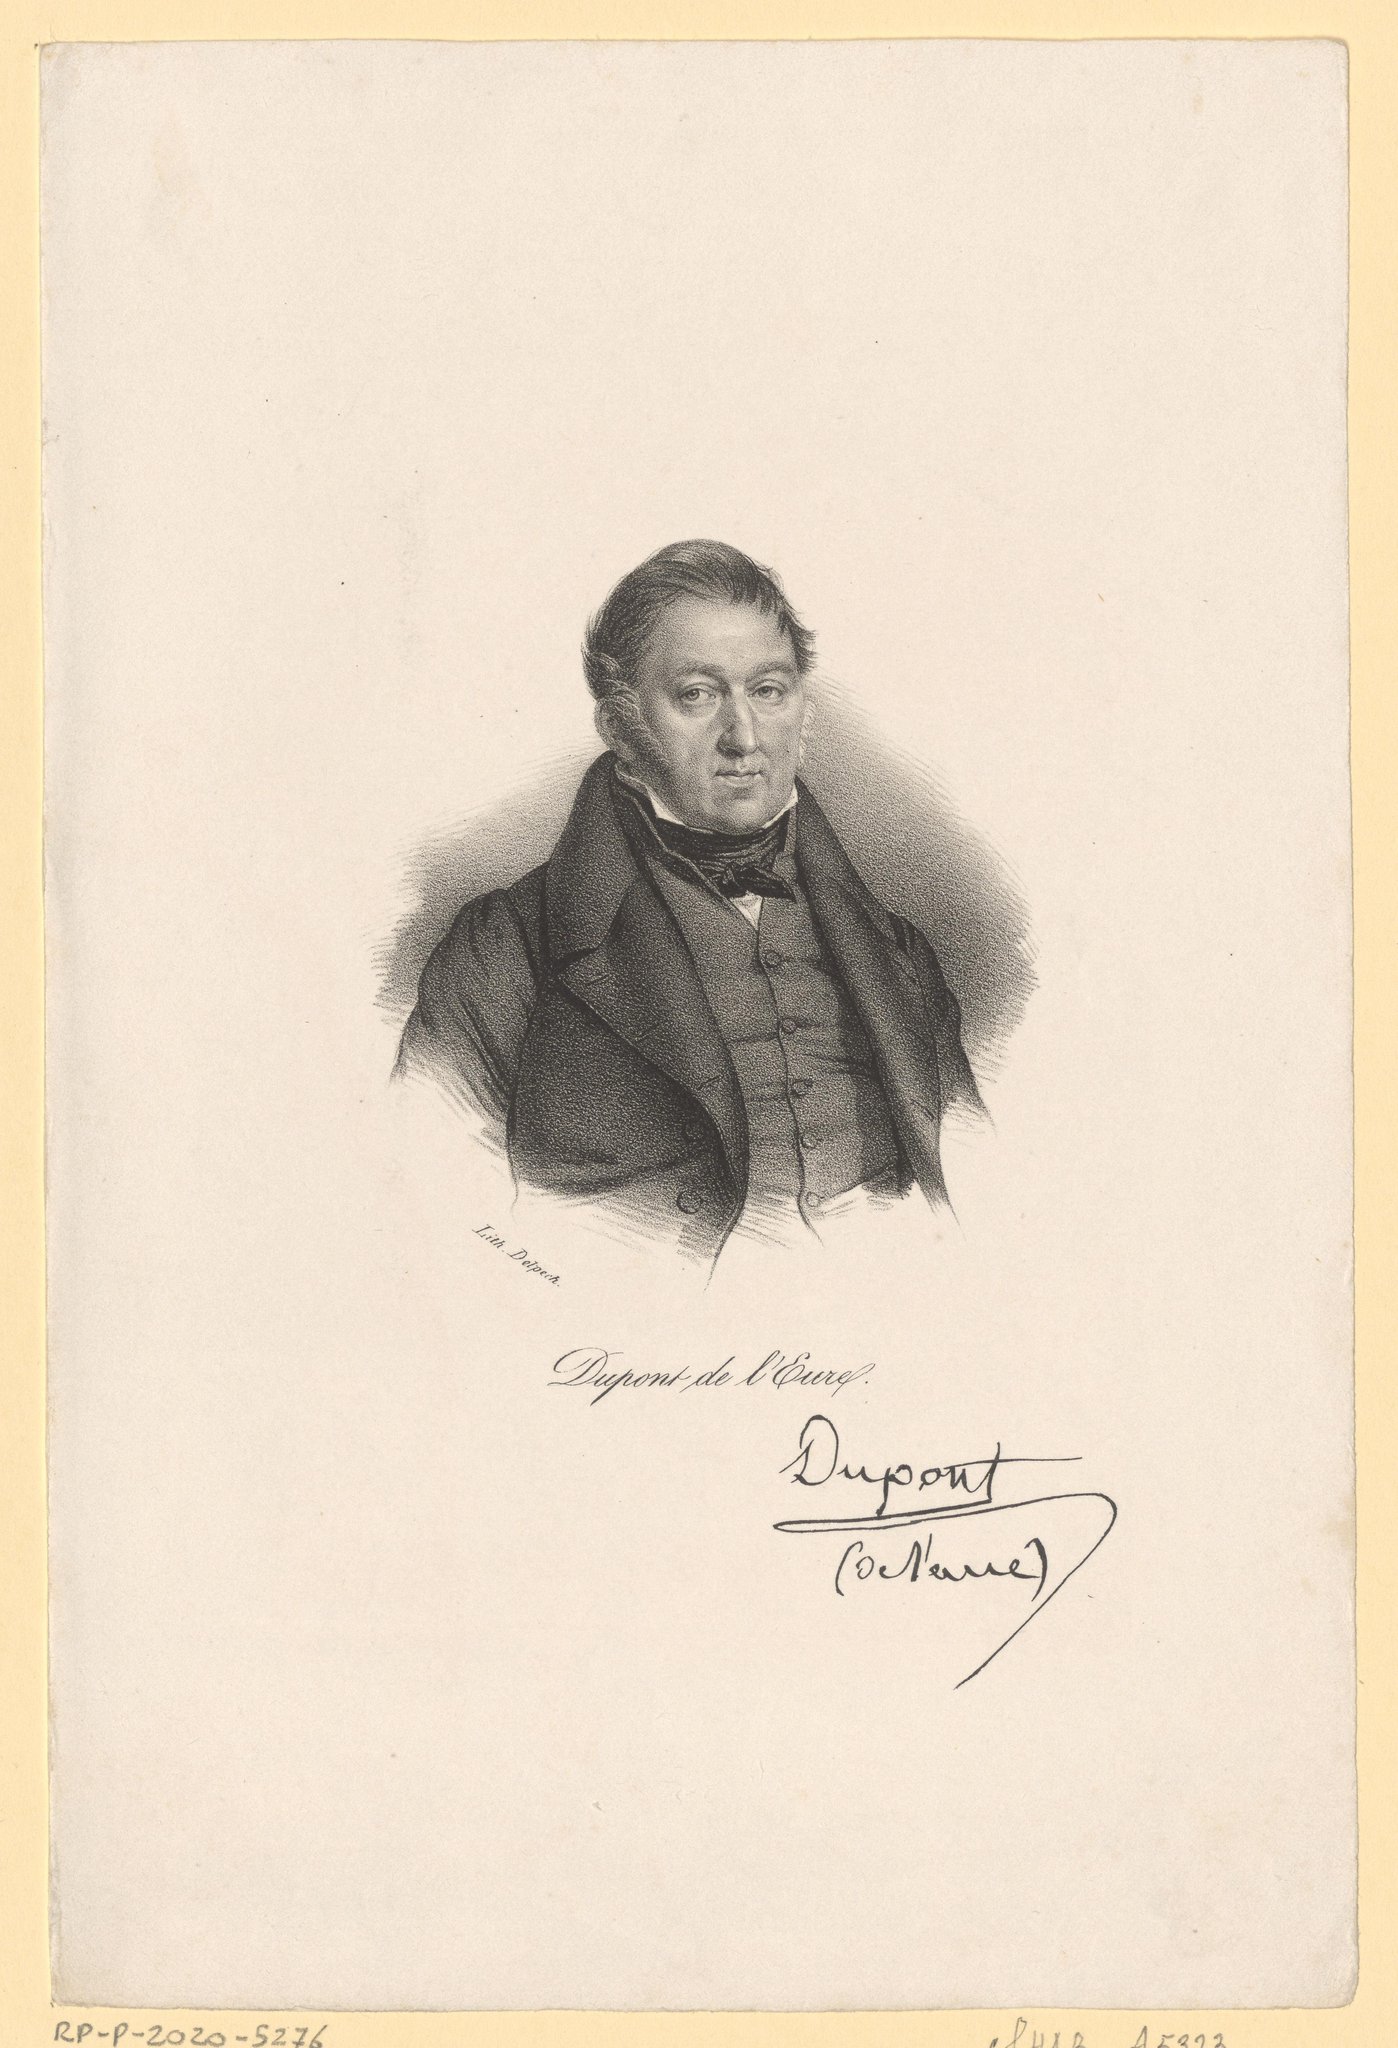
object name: print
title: Portret van Jacques Charles Dupont de l'Eure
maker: Anonymous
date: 1842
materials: paper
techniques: lithograph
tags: politician, historical persons, politician, e.g. party leader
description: Andere staat van prent waarschijnlijk gebruikt voor: Célébrités contemporaines ou portraits des personnes de notre époque (…). Parijs: veuve Delpech, 1842.